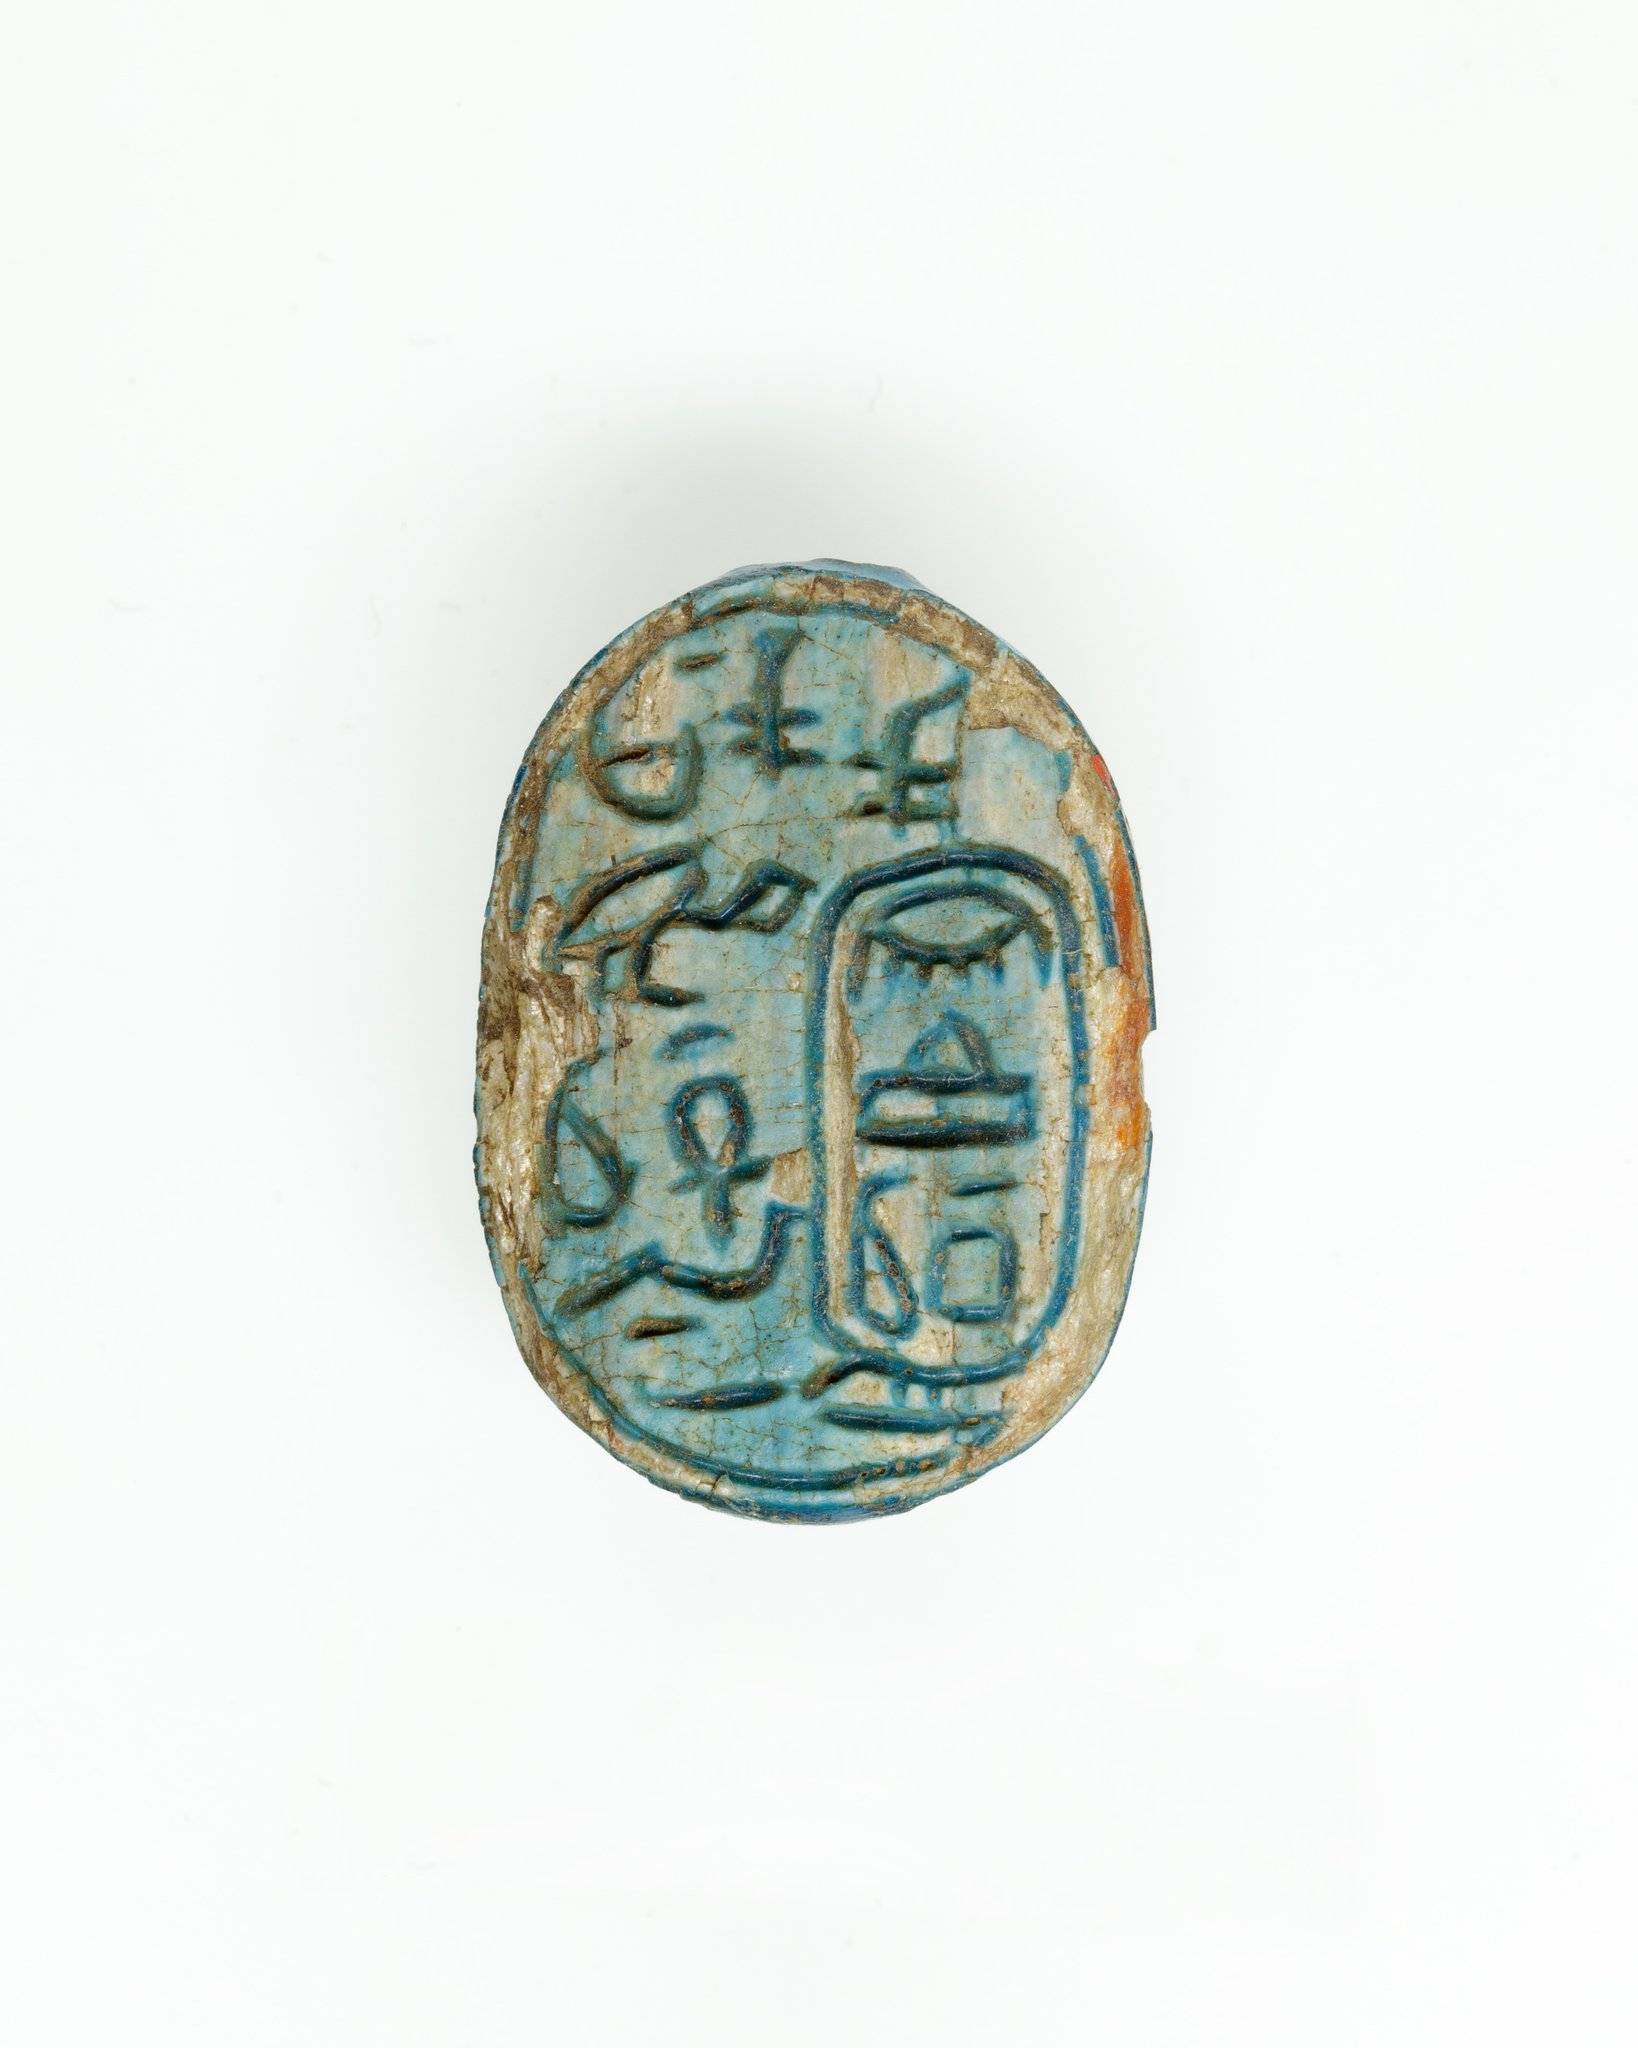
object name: scarab, queen nebuhetepti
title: Scarab of the King's Mother Queen Nebuhetepti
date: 1802-1640 BCE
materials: stone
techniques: glazing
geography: egypt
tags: hieroglyphs,scarabs